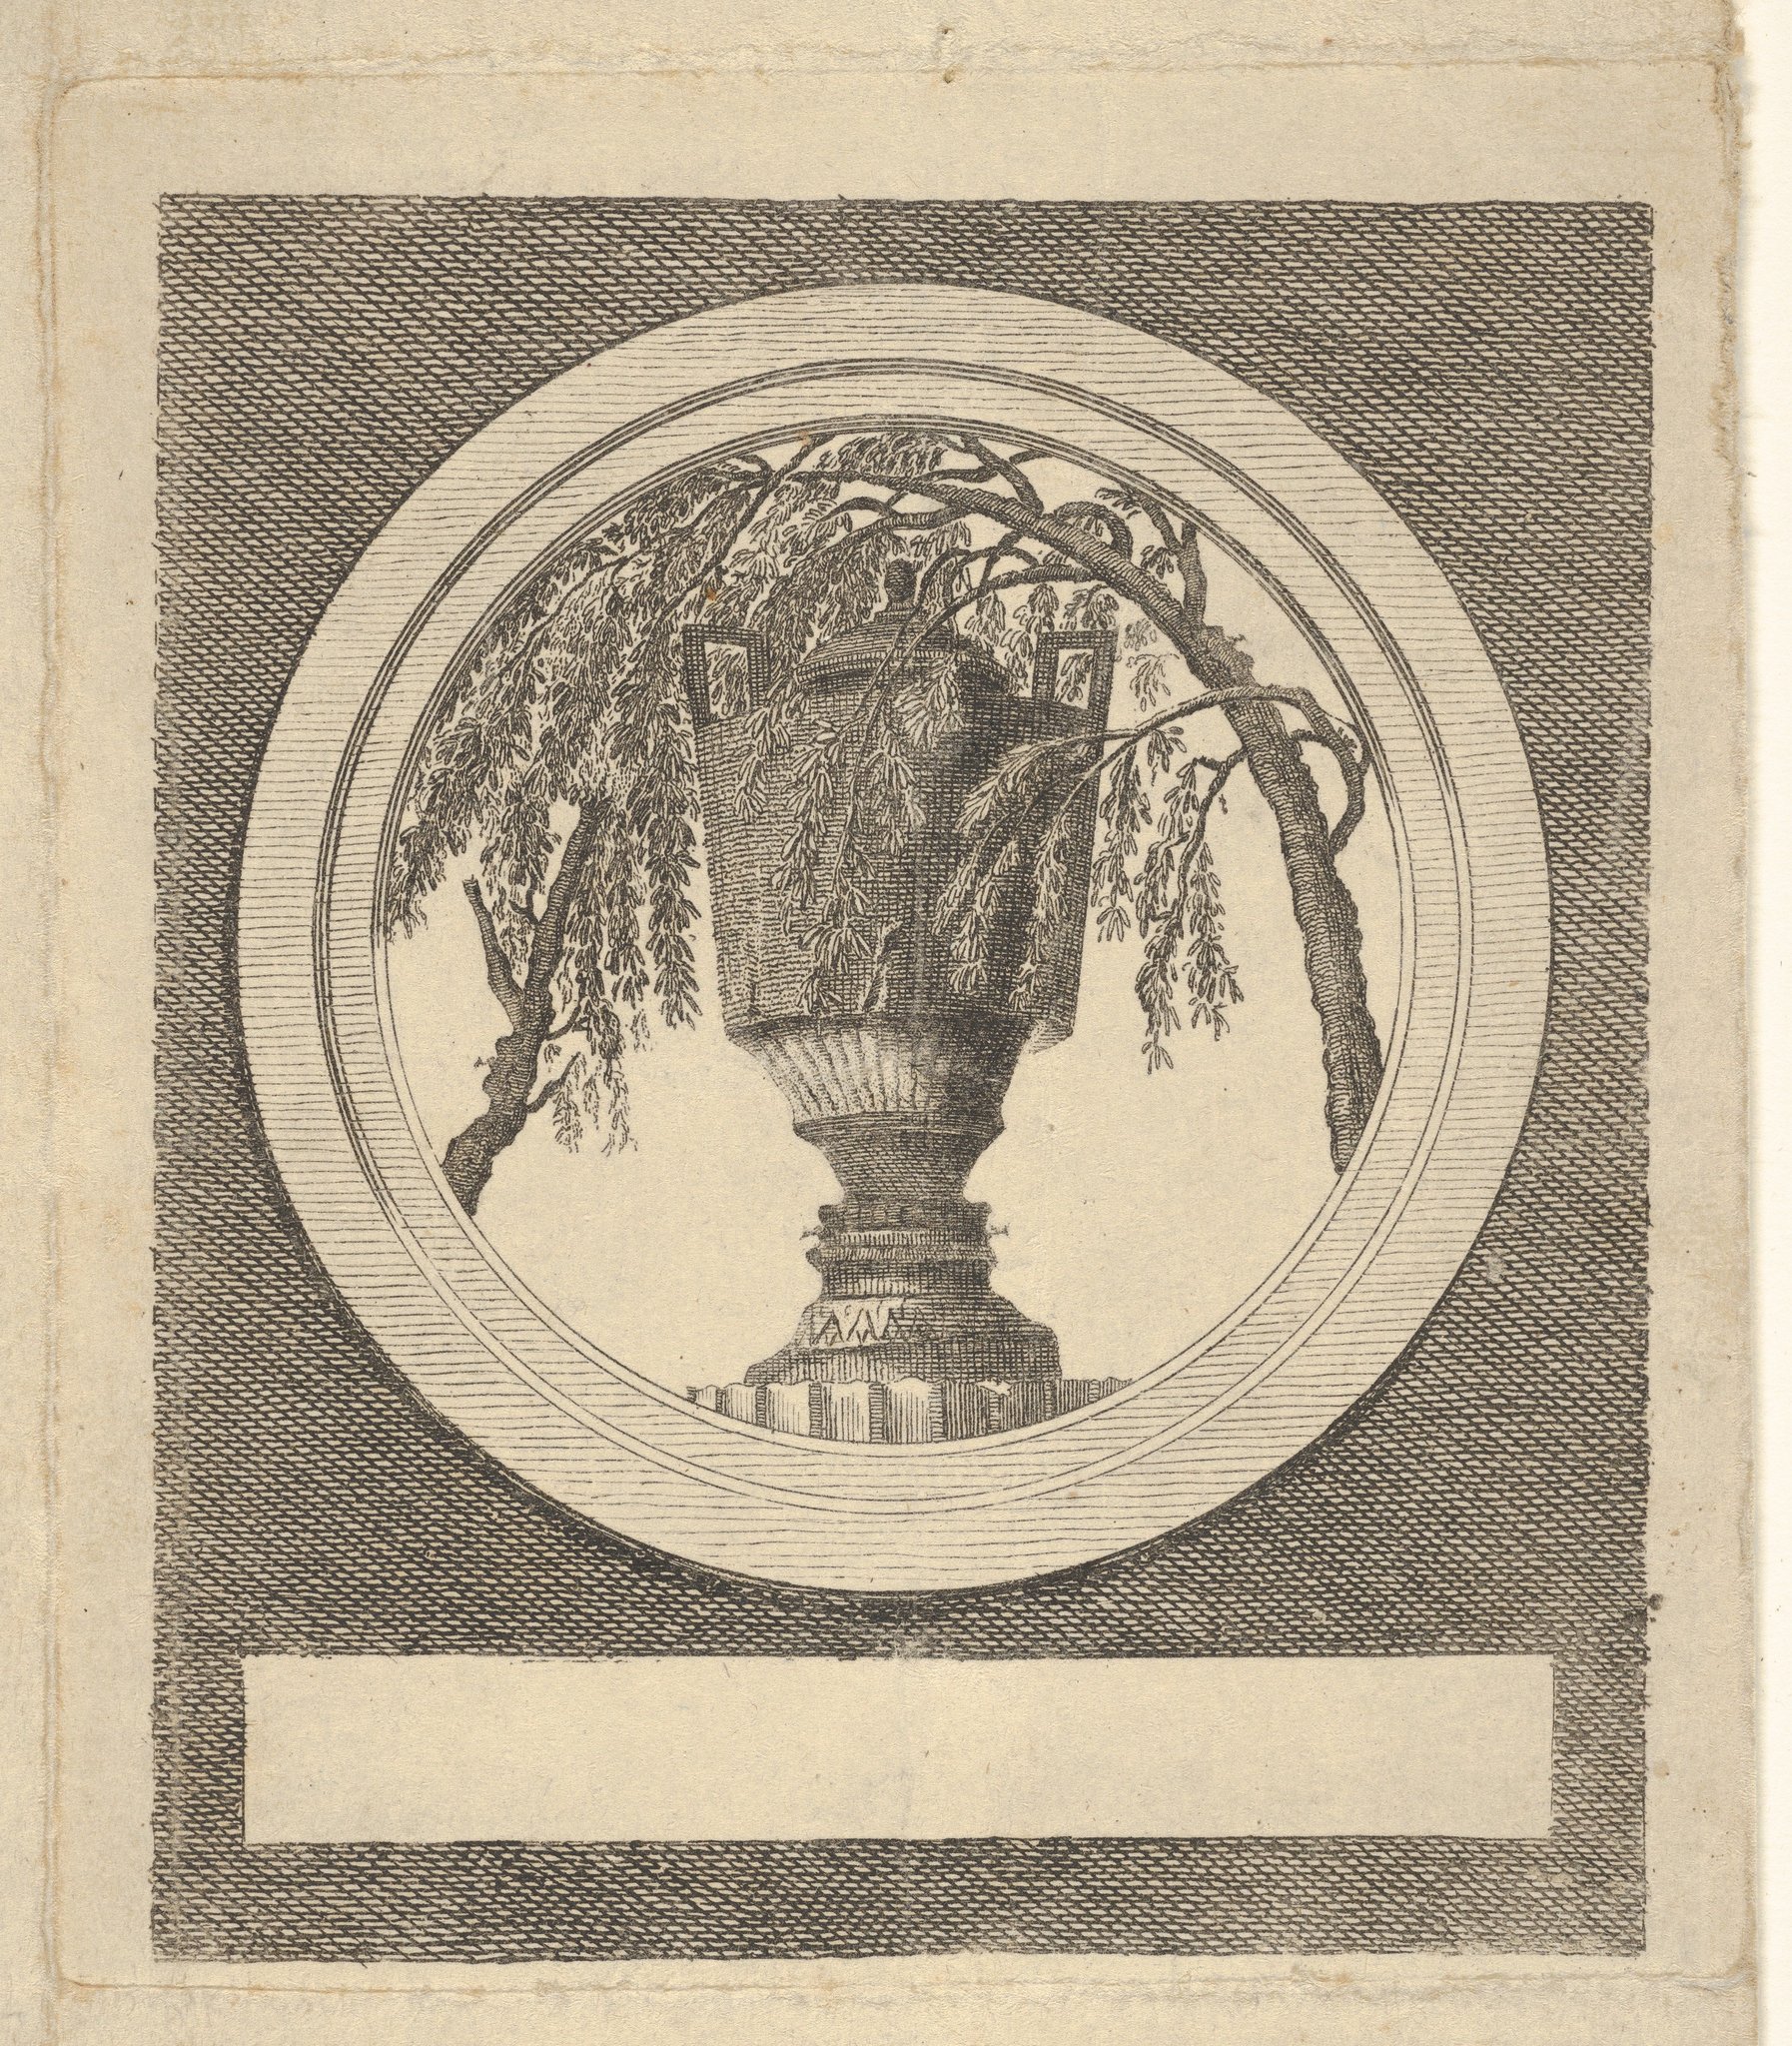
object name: print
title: Royalist trompe l'oeil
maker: anonymous, french, 18th century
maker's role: artist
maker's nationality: french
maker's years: 1700-1800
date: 1701-1800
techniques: engraving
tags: vases